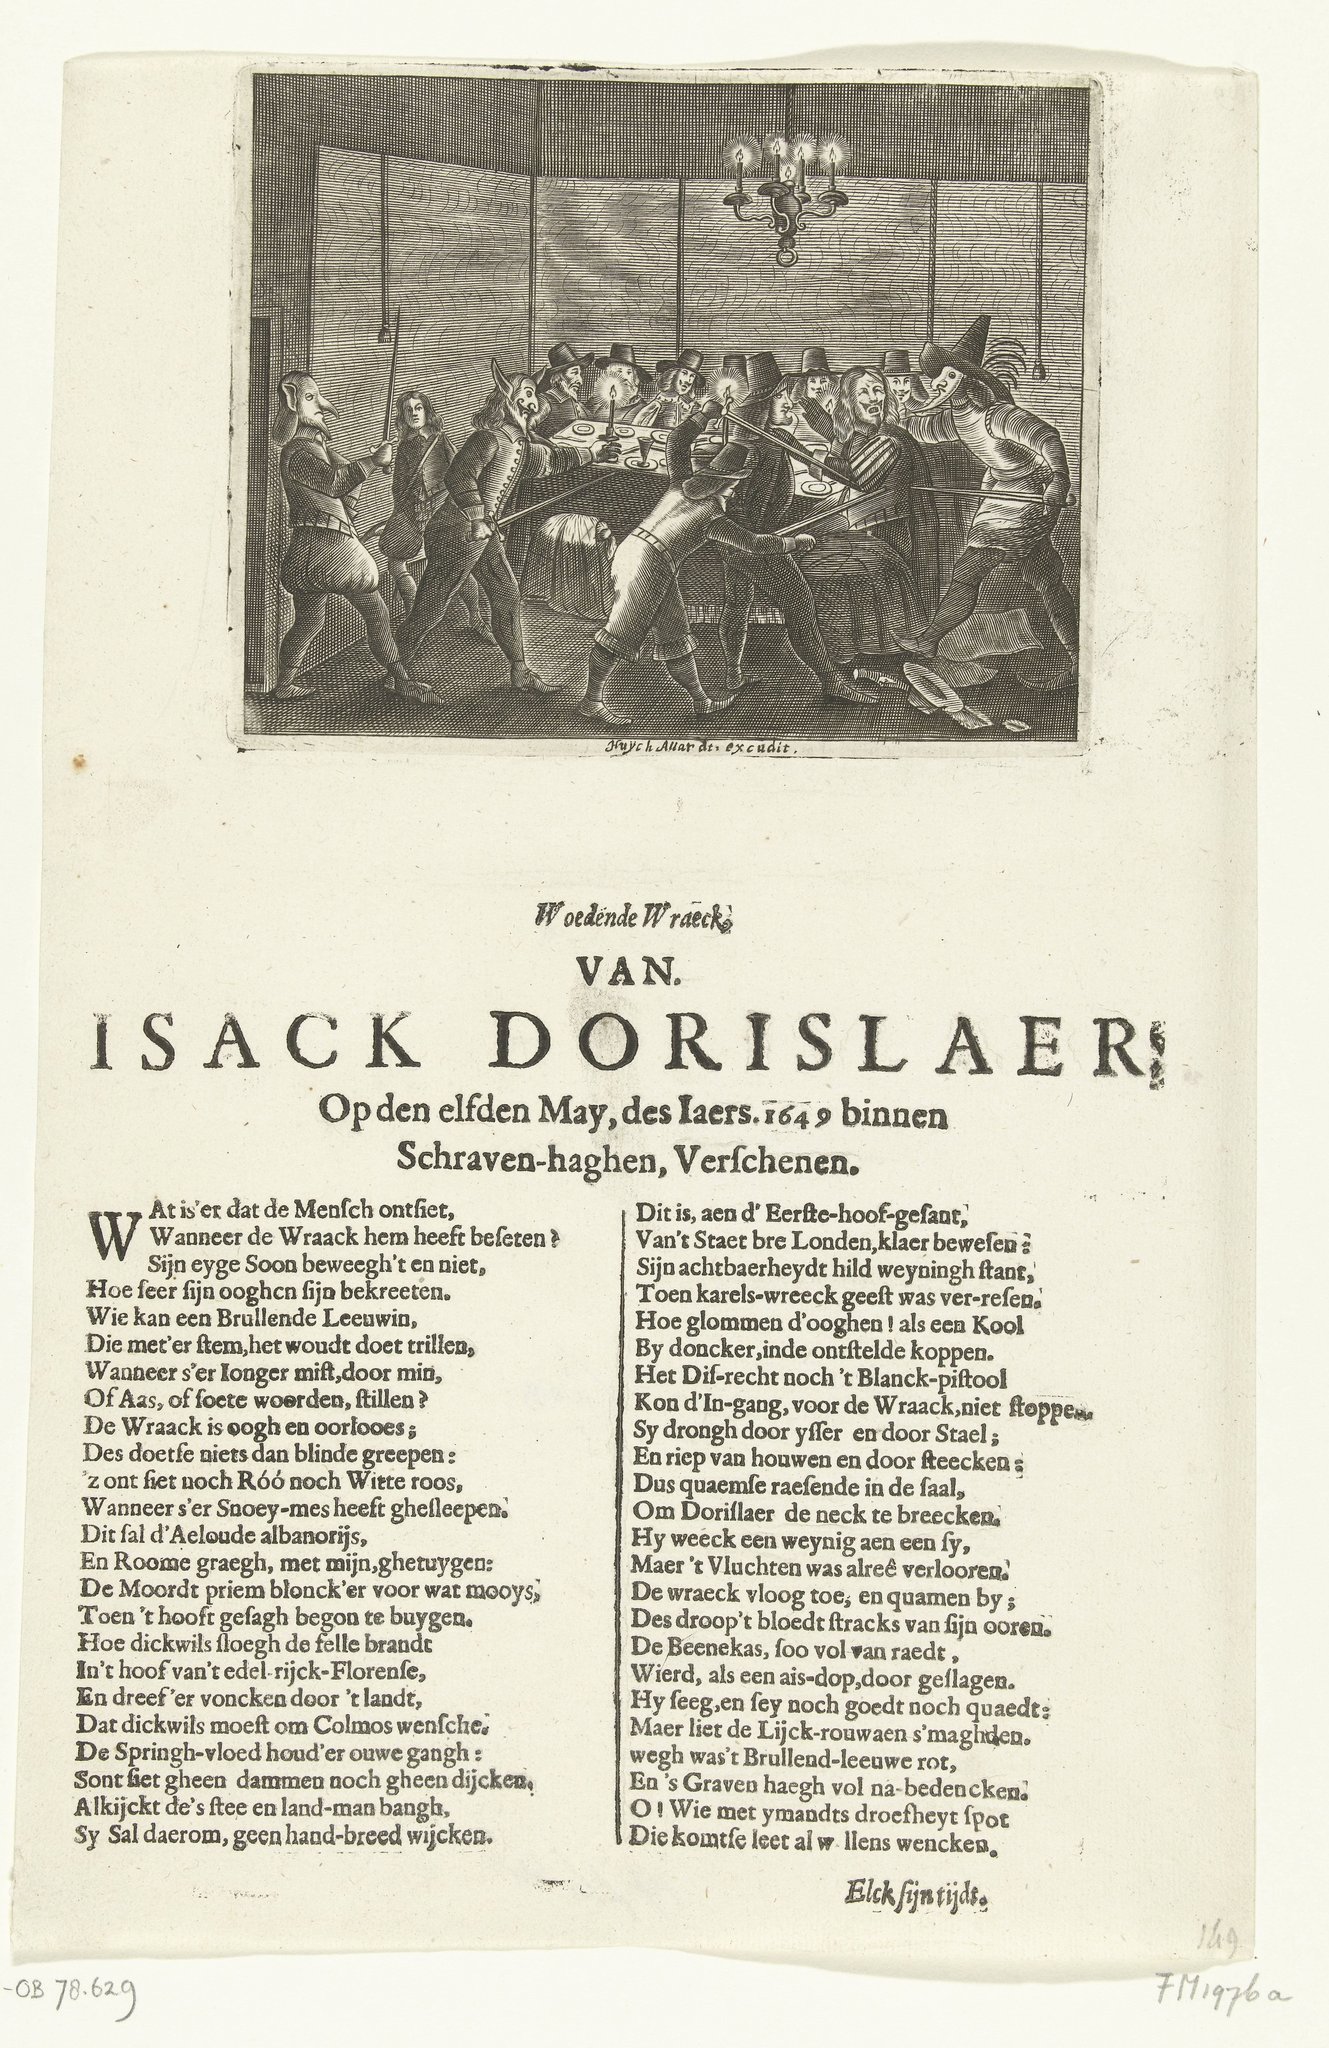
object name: print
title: Woedende Wraeck van Isack Dorislaer Op den elfden May, des Iaers. 1649 binnen Schraven-haghen, Verschenen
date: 1649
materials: paper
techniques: engraving, letterpress printing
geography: northern netherlands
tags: murder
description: De moord gepleegd op Isaäc Dorislaer door een groep gemaskerde mannen in herberg De Zwaan op de Plaats te 's-Gravenhage, 12 mei 1649. Doreslaer was als gezant door Cromwell uit Engeland naar de Republiek gezonden. Op het blad is onder de prent een vers in 2 kolommen gedrukt, gesigneerd: Elck sijn tijdt.